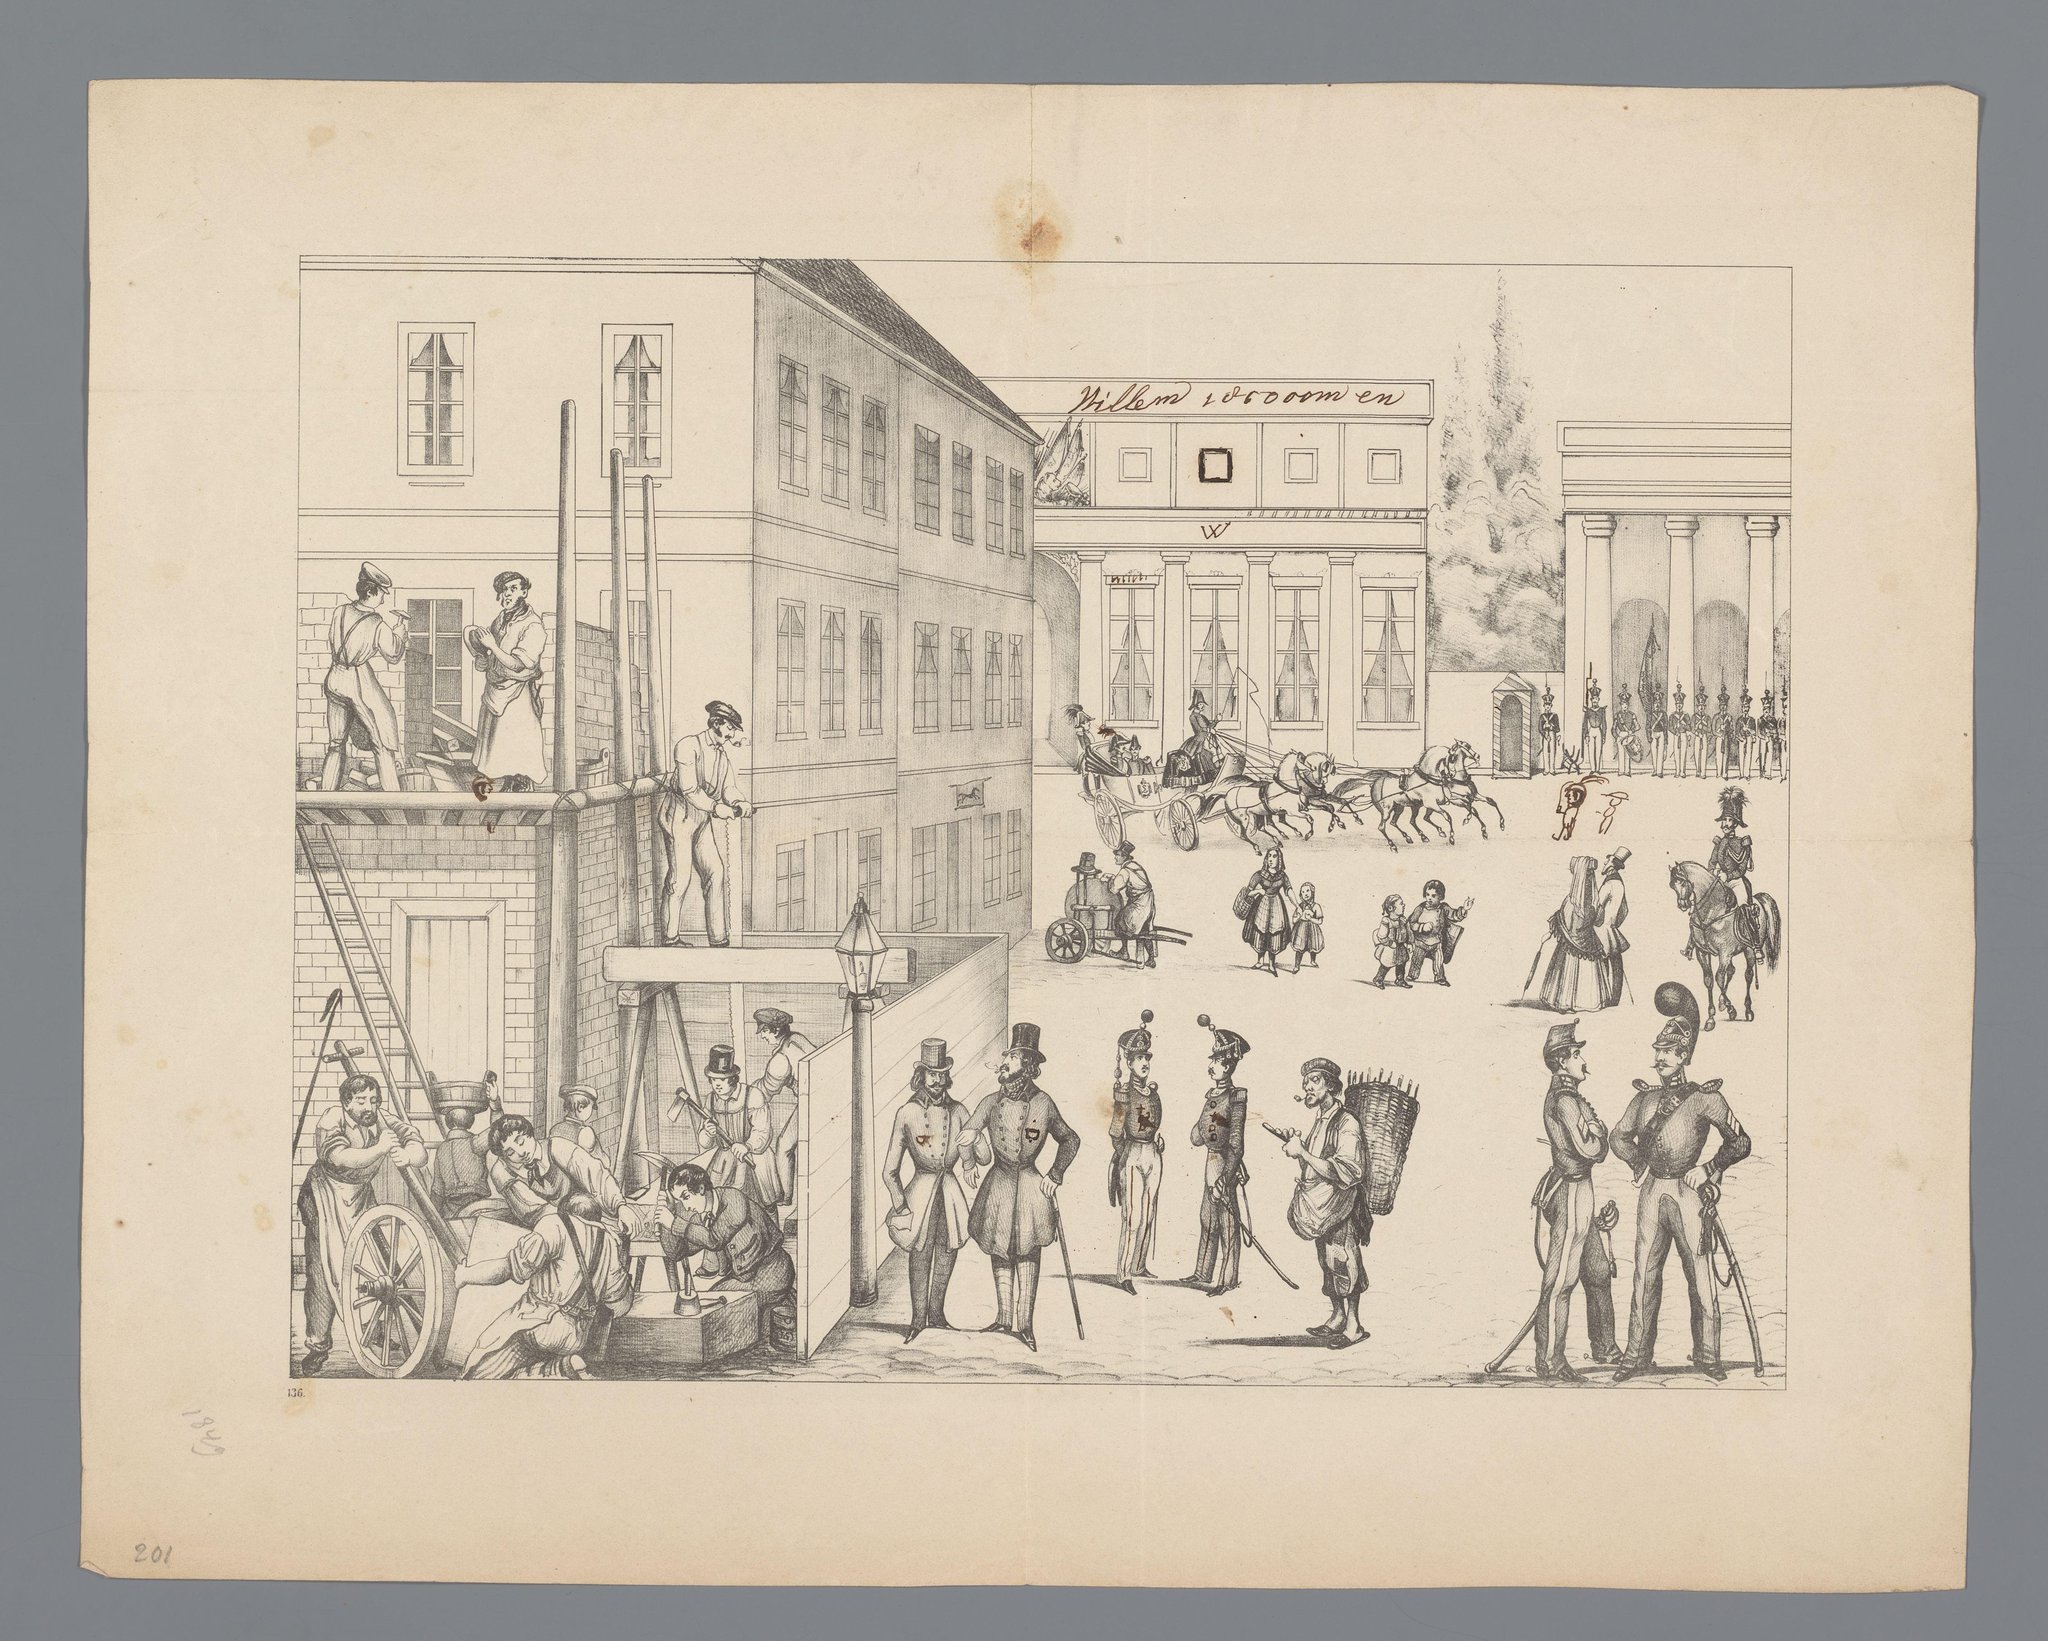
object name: print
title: Stadsgezicht met diverse figuren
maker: Anonymous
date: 1849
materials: paper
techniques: lithograph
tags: city-view in general; 'veduta', brussels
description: De prent bevat opschriften en aanpassingen in inkt. Onder meer zijn er twee figuren op straat bij getekend en staat er een opschrift op een gebouw.